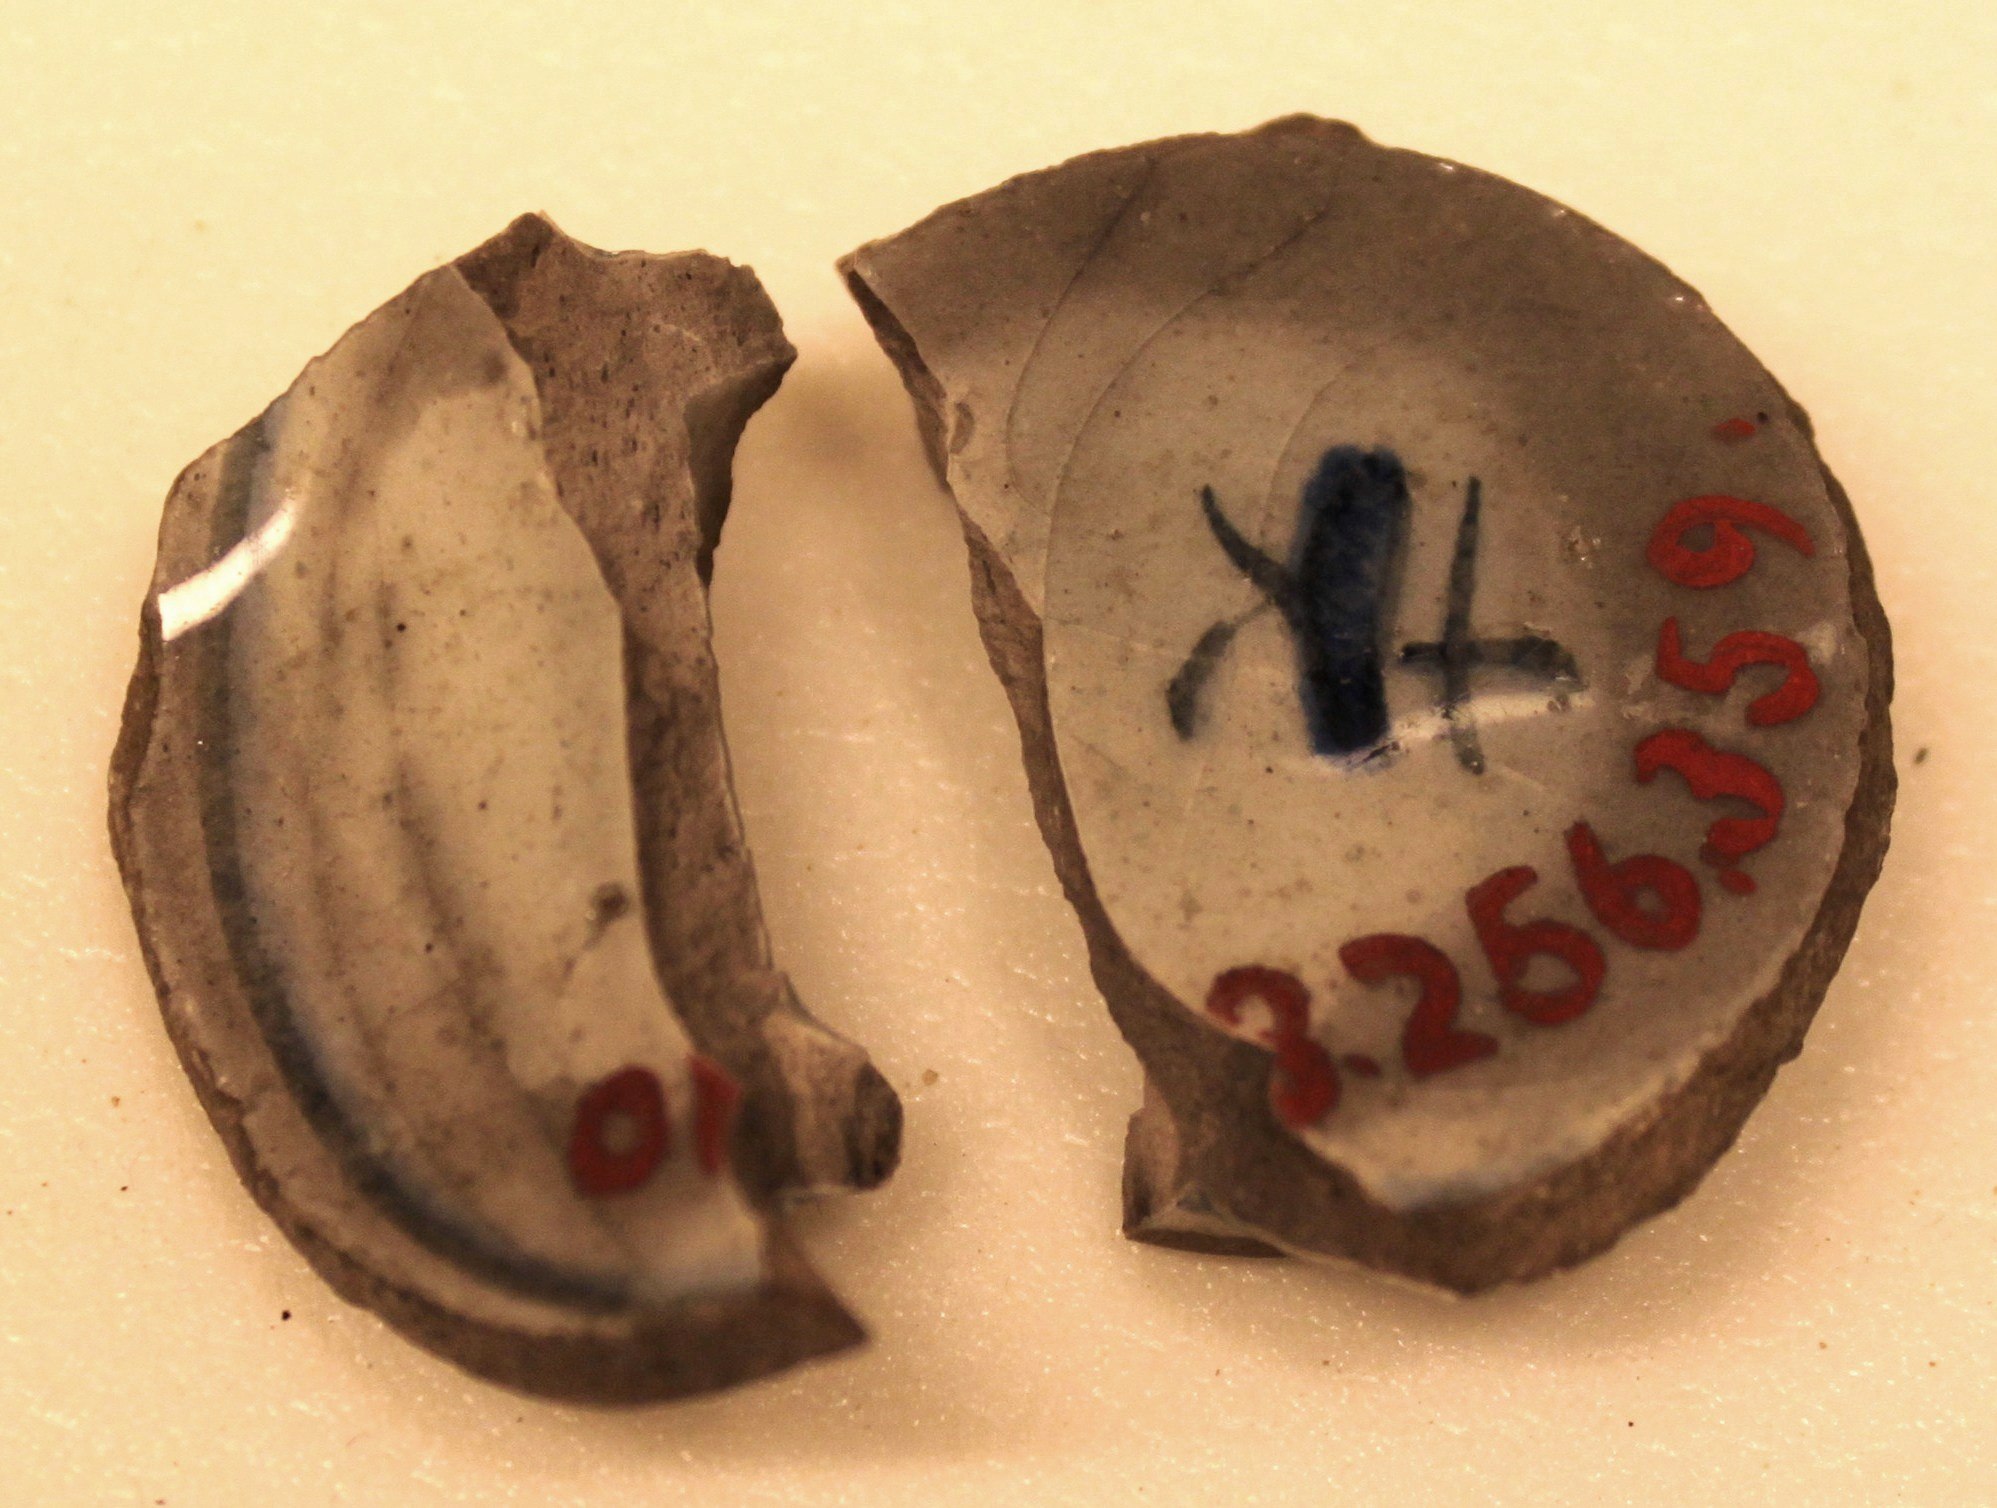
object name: fragment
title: Fragment of a Cup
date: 1301-1500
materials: earthenware, glaze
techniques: incising, polychrome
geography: egypt